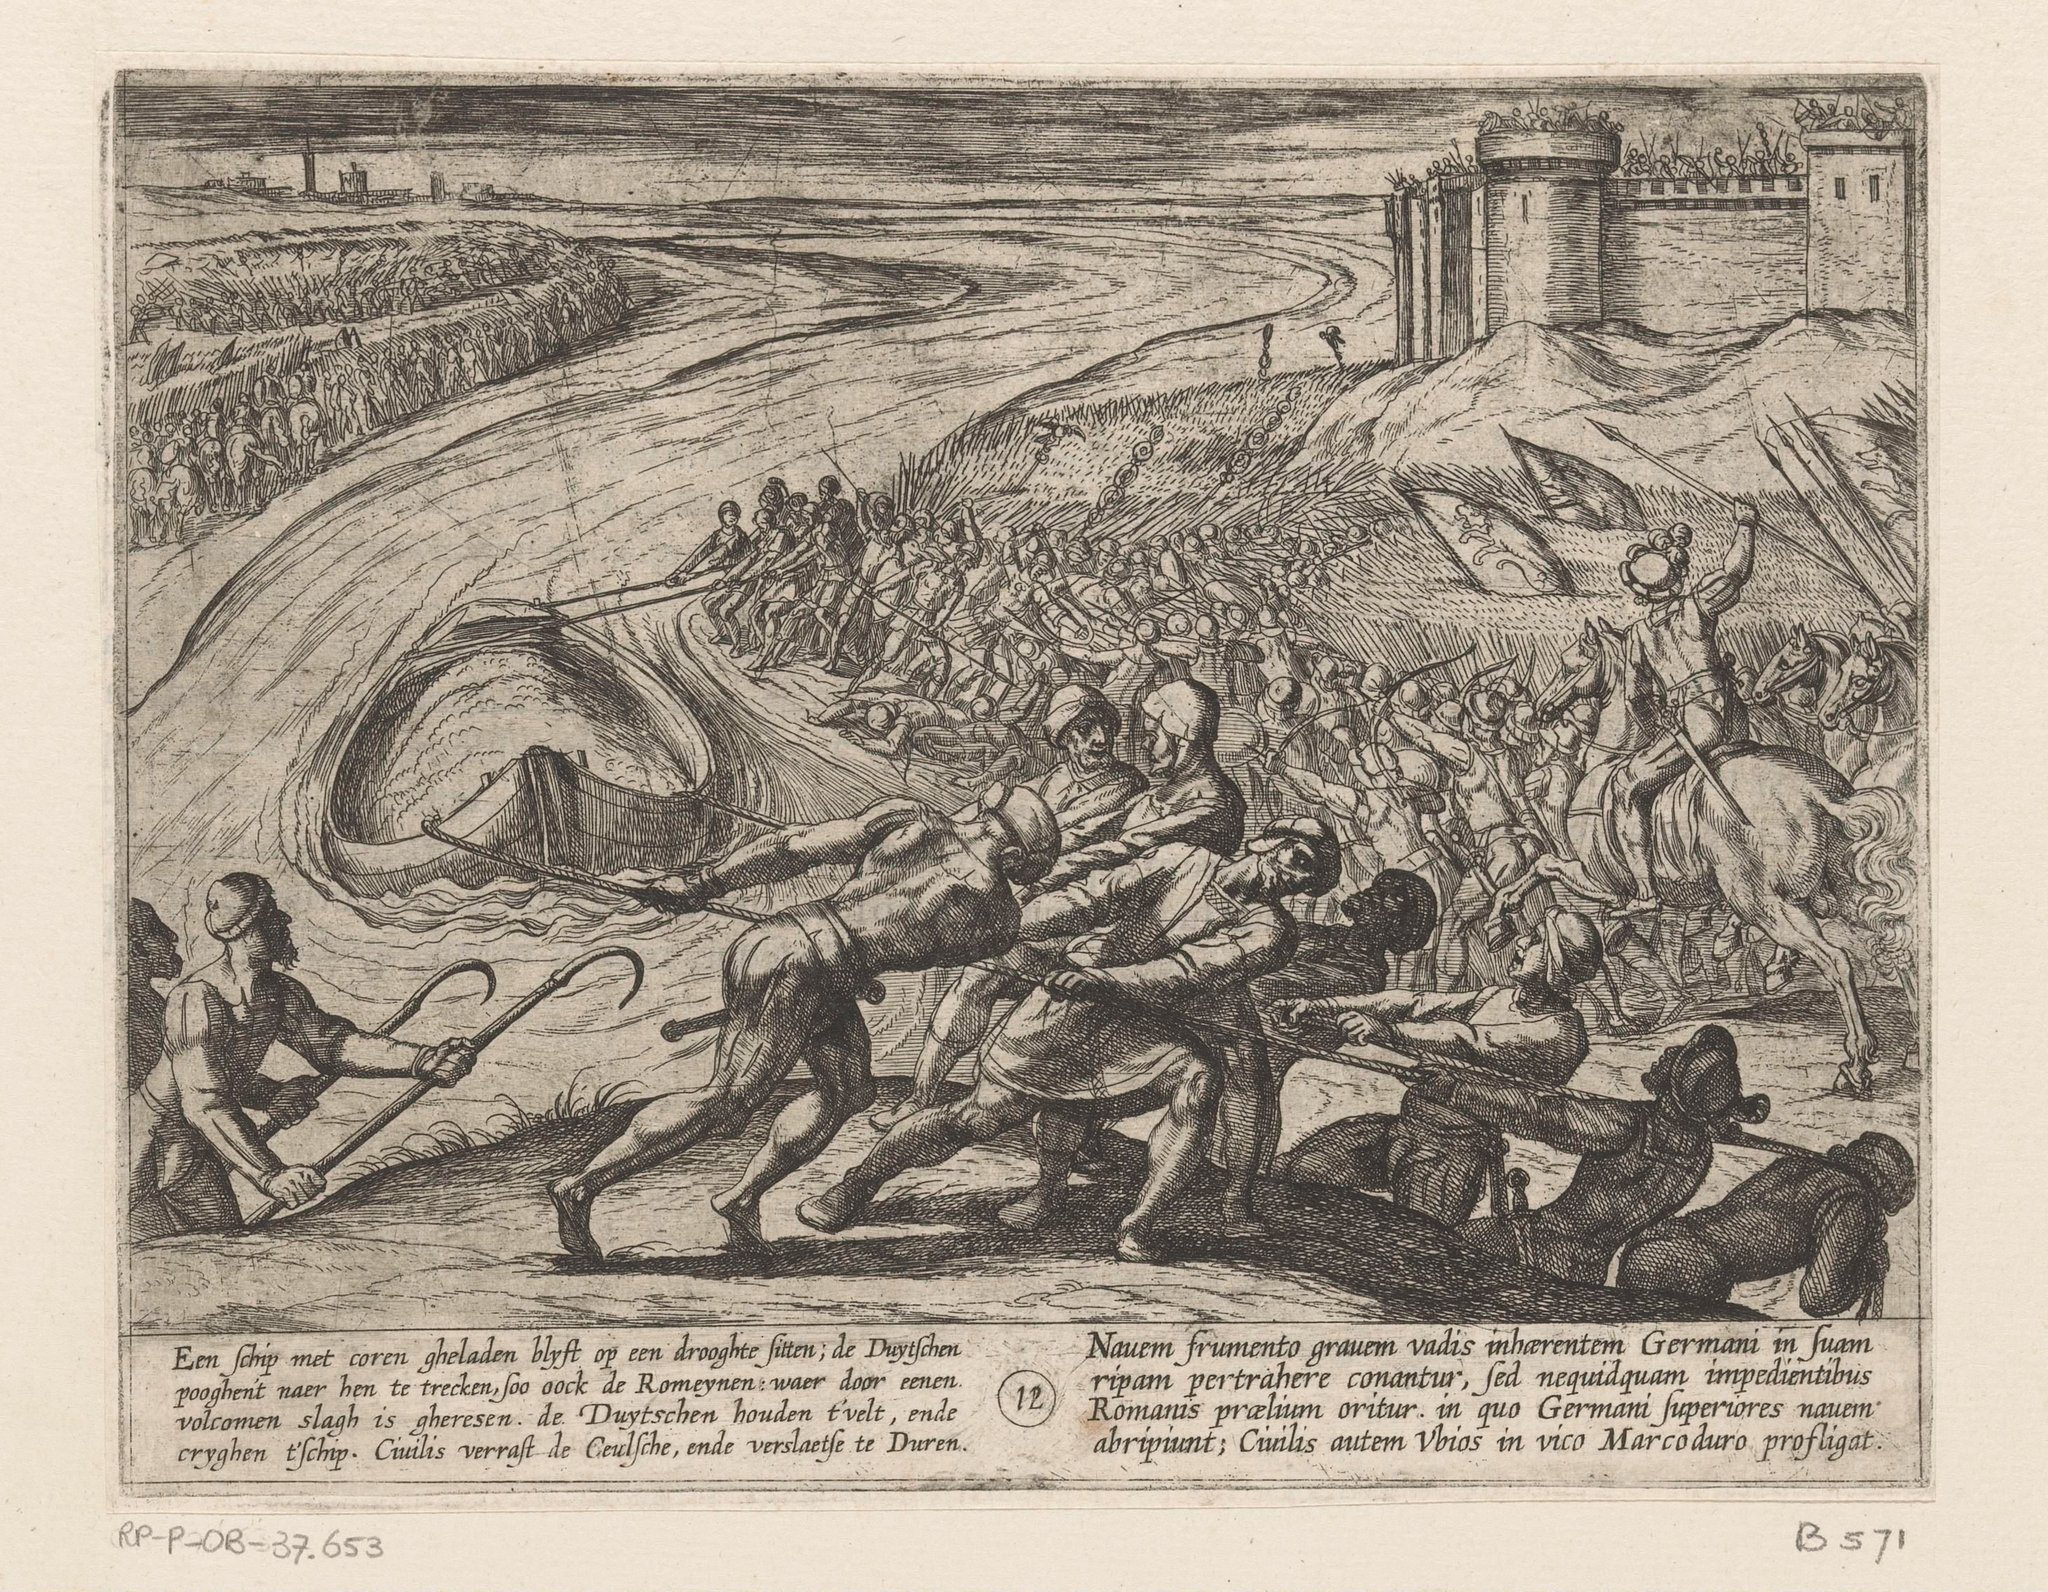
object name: print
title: Batavorum cum Romanis Bellum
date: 1611-1612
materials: paper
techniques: etching, letterpress printing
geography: southern netherlands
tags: battle, cereal, grain, corn (grass with grains, grown for food, e.g.: wheat, rice, rye, oats, maize, buckwheat, millet), the soldier; the soldier's life, extinct, 'historical' peoples (with name)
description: De Bataven en de Romeinen proberen beiden een vastgelopen schuit vol graan naar de kust te trekken. Onderschrift in het Nederlands en in het Latijn.